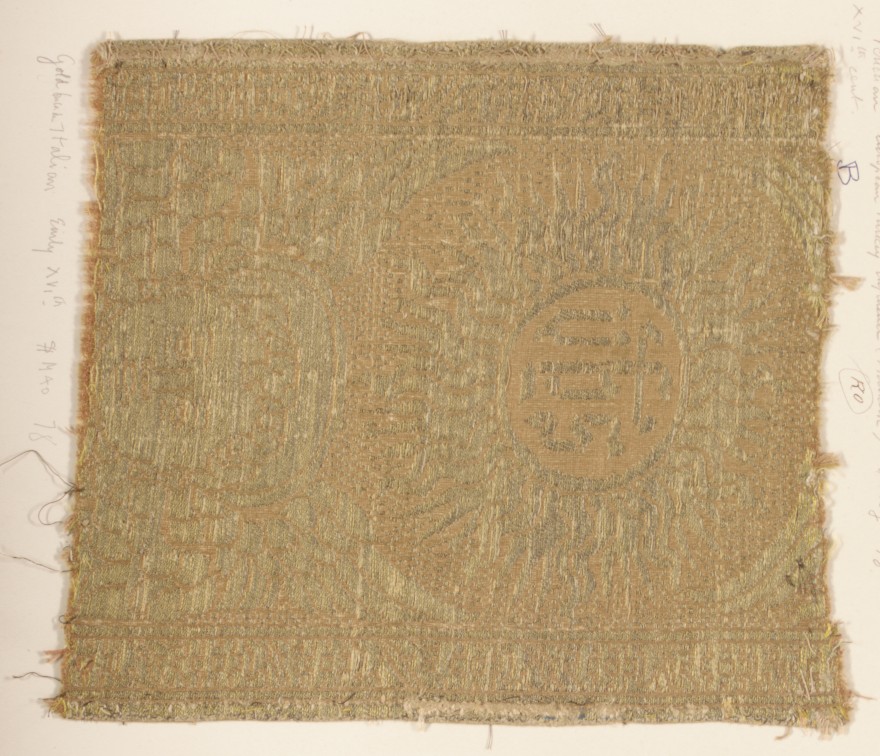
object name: fragment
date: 1601-1633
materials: metal thread, silk